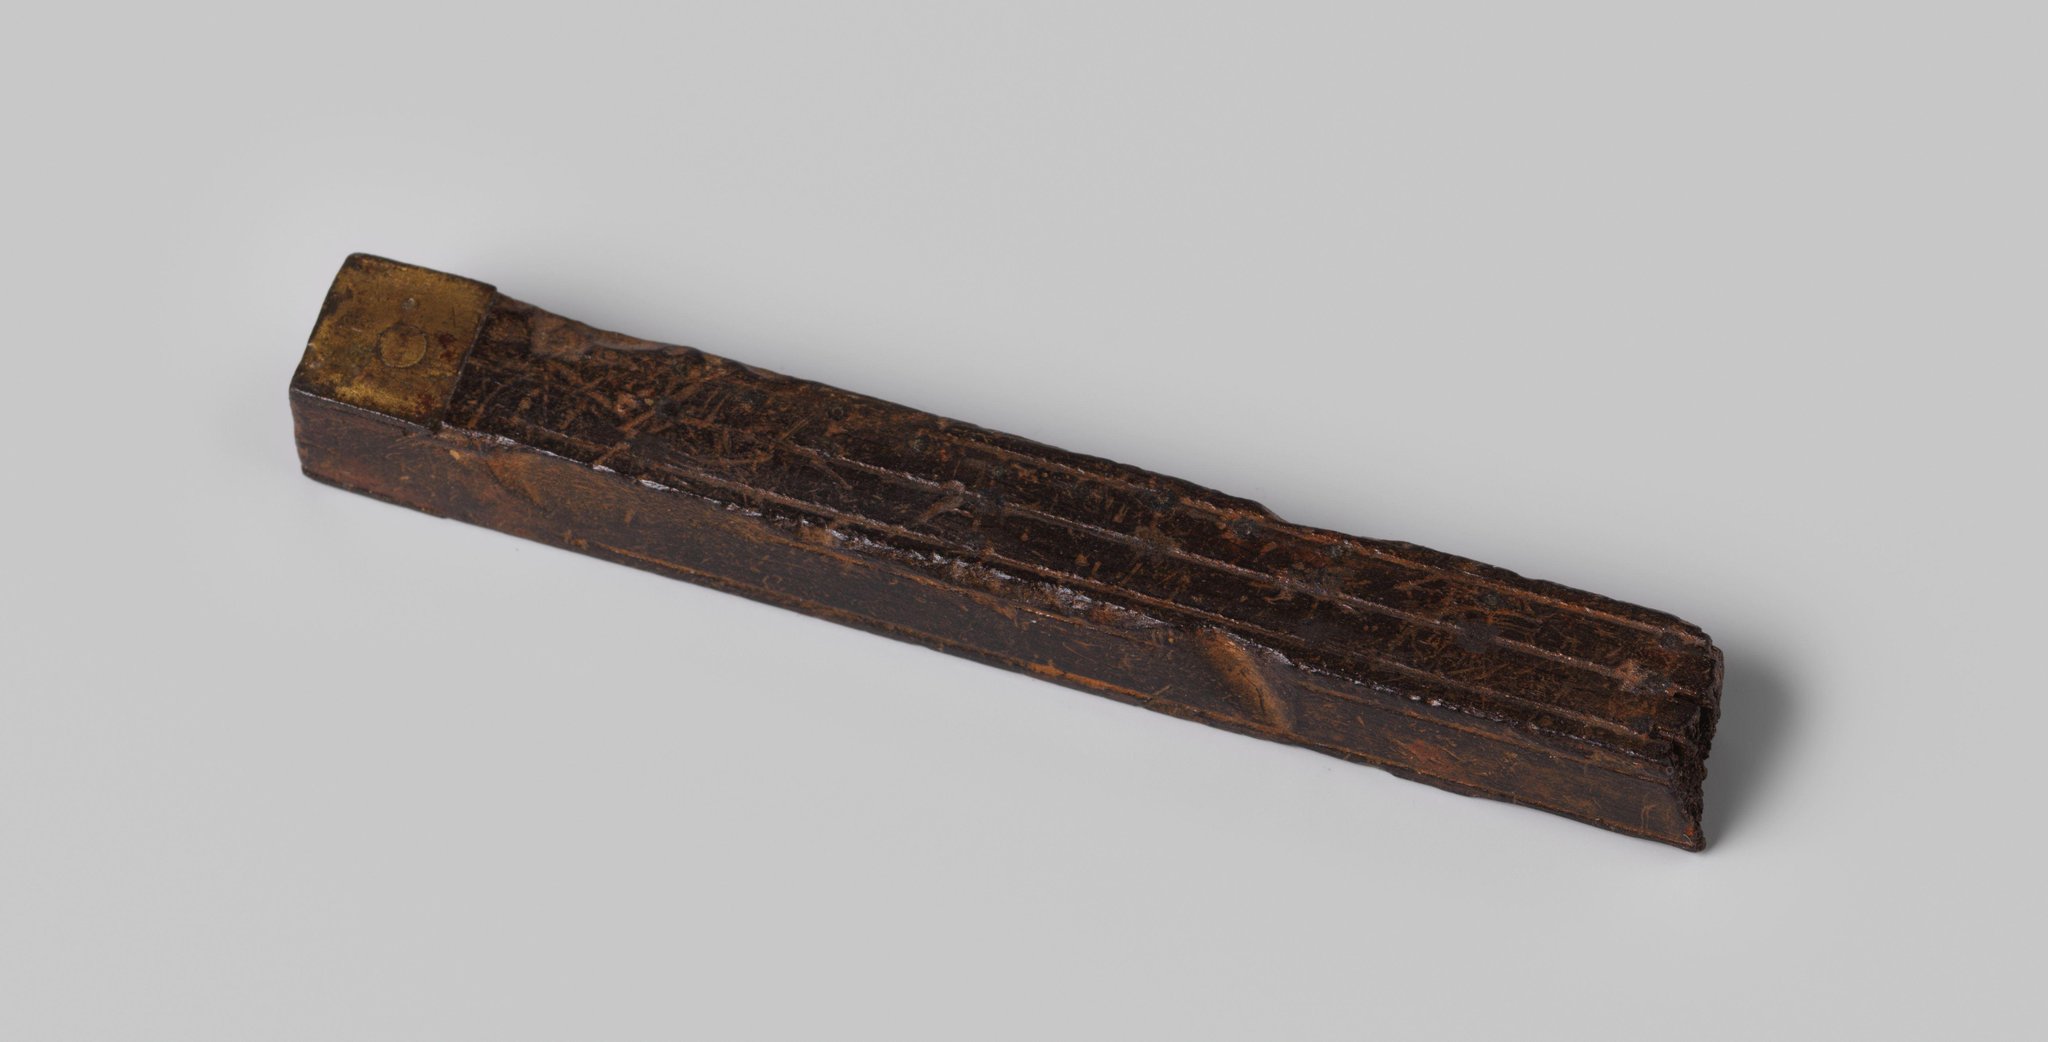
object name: measuring rod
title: Meetlat uit het wrak van de Oost-Indiëvaarder Hollandia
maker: Anonymous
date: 1700-1743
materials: copper, wood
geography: netherlands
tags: verenigde oostindische compagnie, hollandia (schip), annet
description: Fragm; rectangular stick, one end broken, straight end fitted with 2 square plates, engraved scale with small nails on one side, straight engraved lines on other sides.